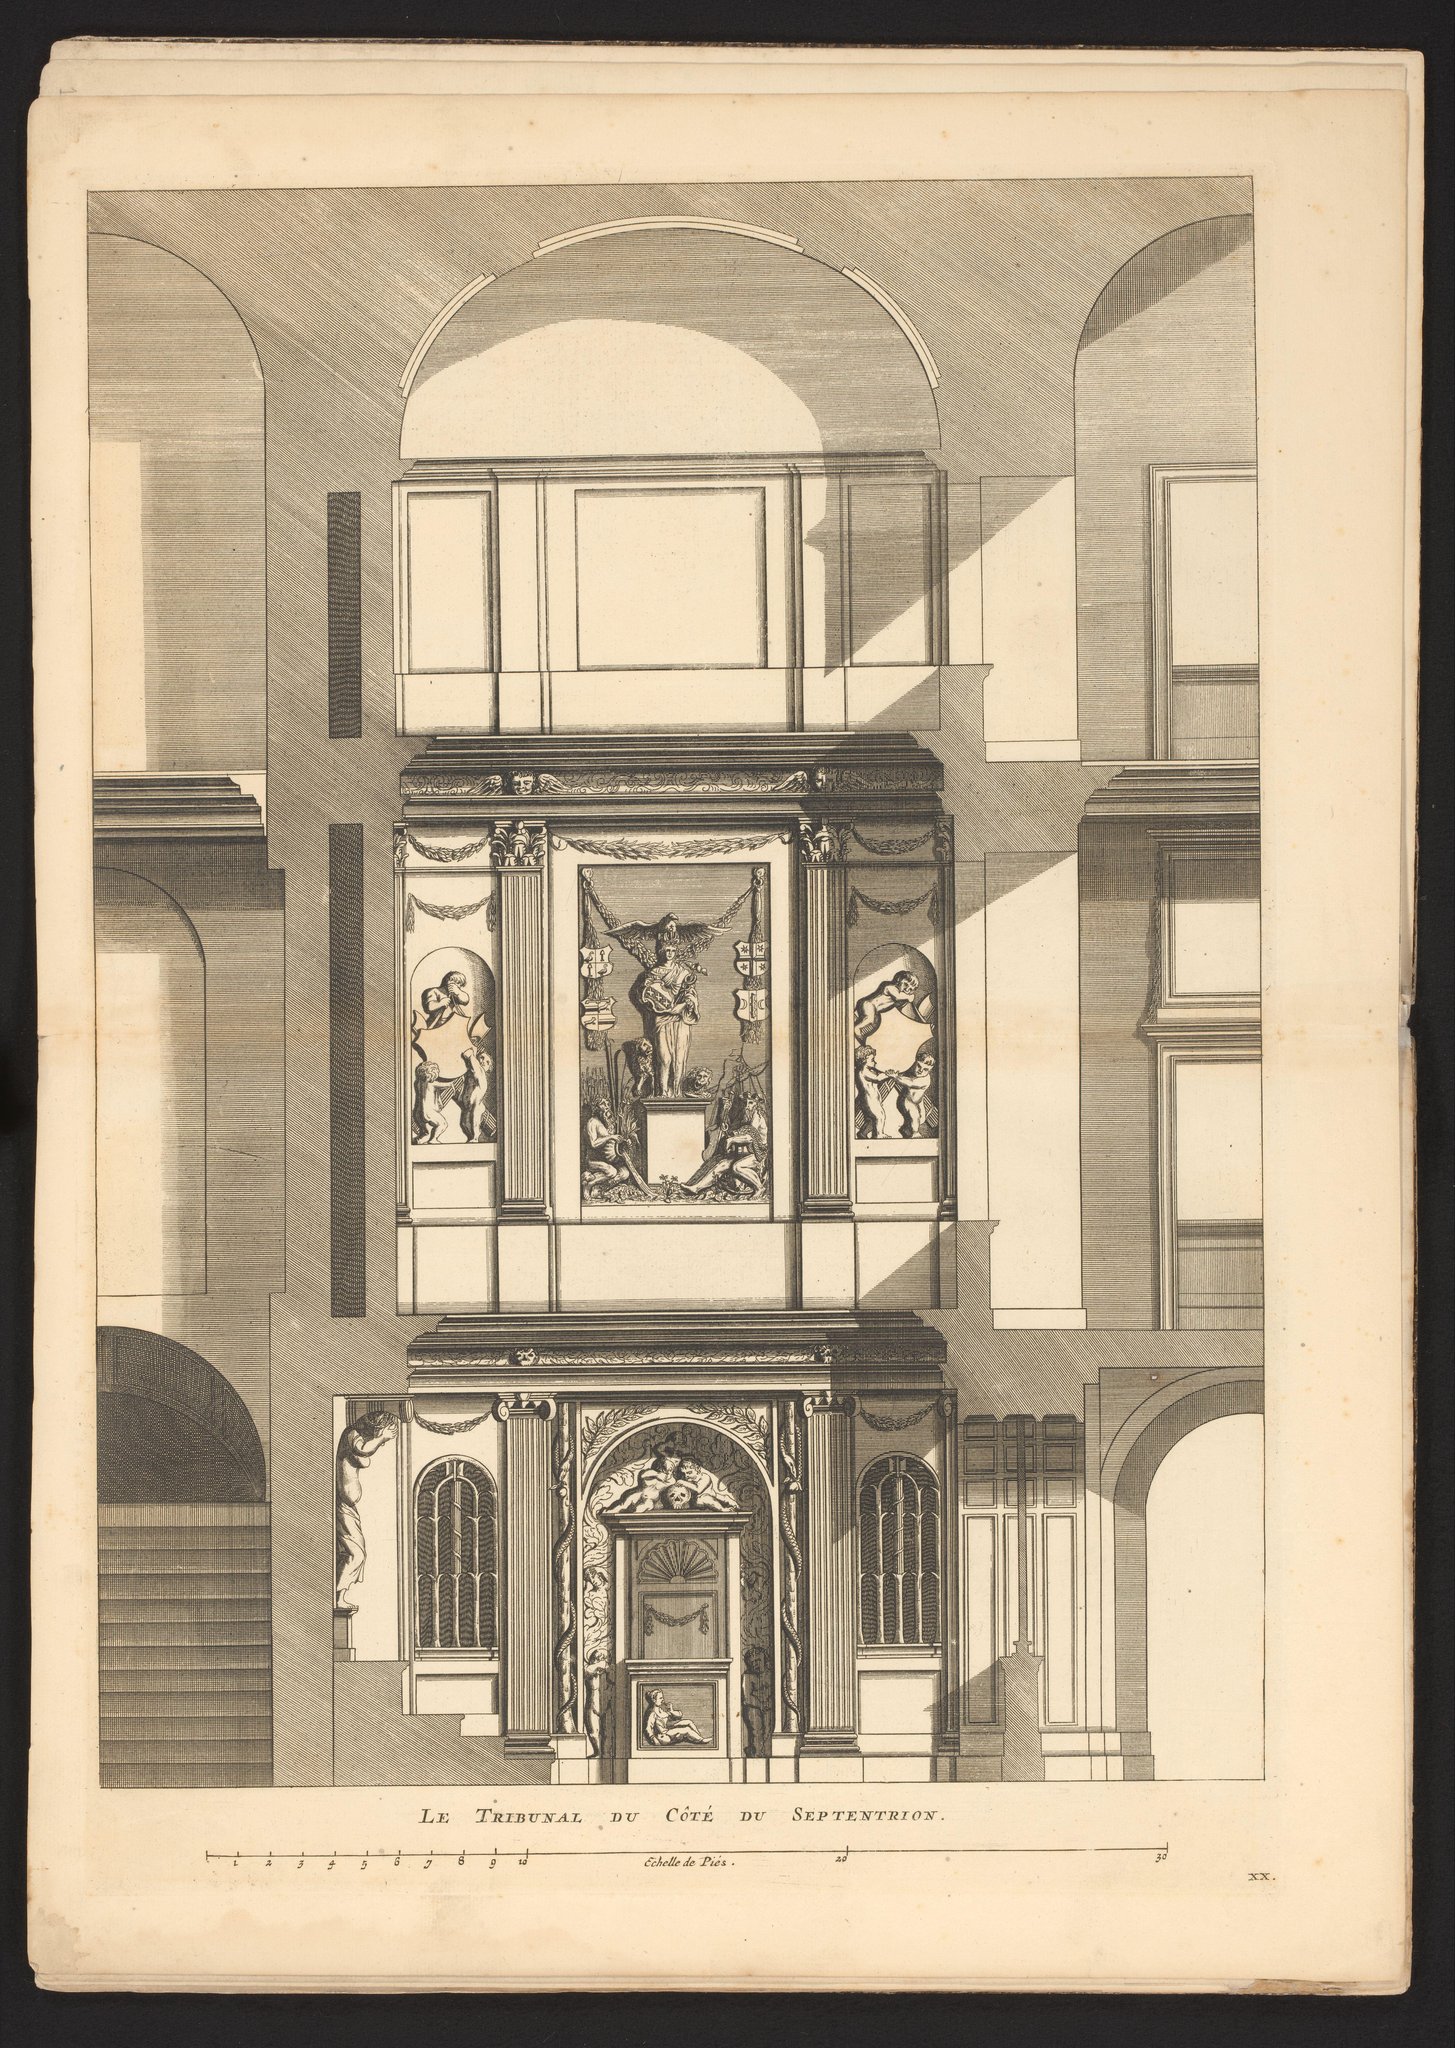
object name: print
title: Le Tribunal du Côté du Septentrion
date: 1719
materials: paper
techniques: engraving, etching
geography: amsterdam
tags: coat of arms (as symbol of the state, etc.) (+ city; municipal), personification of a city, town-patron(ess), river personified, 'fiumi' (ripa), river-gods, townhall, sculpture, caduceus (staff with two snakes, attribute of mercury), beasts of prey, predatory animals: lion, cupids: 'amores', 'amoretti', 'putti', armorial bearing, heraldry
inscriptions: collector's mark: ‘Instituut voor kunst-nijverheidsonderwijs Gabriël Metsustraat No. 16 Amsterdam’, collector's mark: ‘Kunstnijverheidschool Quellinus Amsterdam Frans Halsstraat 14’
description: Prent waarschijnlijk uit: Architecture peinture et sculpture de la Maison de Ville d'Amsterdam, representee en CIX. figures en taille-douce (…). Amsterdam: David Mortier, 1719. Of uit de uitgave van dit werk door Gerard Valck uit 1719, of uit: Bouw schilder en beeldhouwkonst, van het Stadhuis te Amsteldam, vertoont in CIX figuuren (…). Amsterdam: Covens & Mortier & Covens Jr., s.a. (1774-1783). Prent werd in een eerdere staat gebruikt in: Afbeelding van 't stadt huys van Amsterdam, In dartigh Coopere Plaaten, geordineert door Jacob van Campen; en Geteeckent door Iacob Vennekool. Amsterdam: Dancker Danckerts, 1661. En in de editie van dit werk uitgegeven door Frederik de Wit, s.a. [1666-1706].